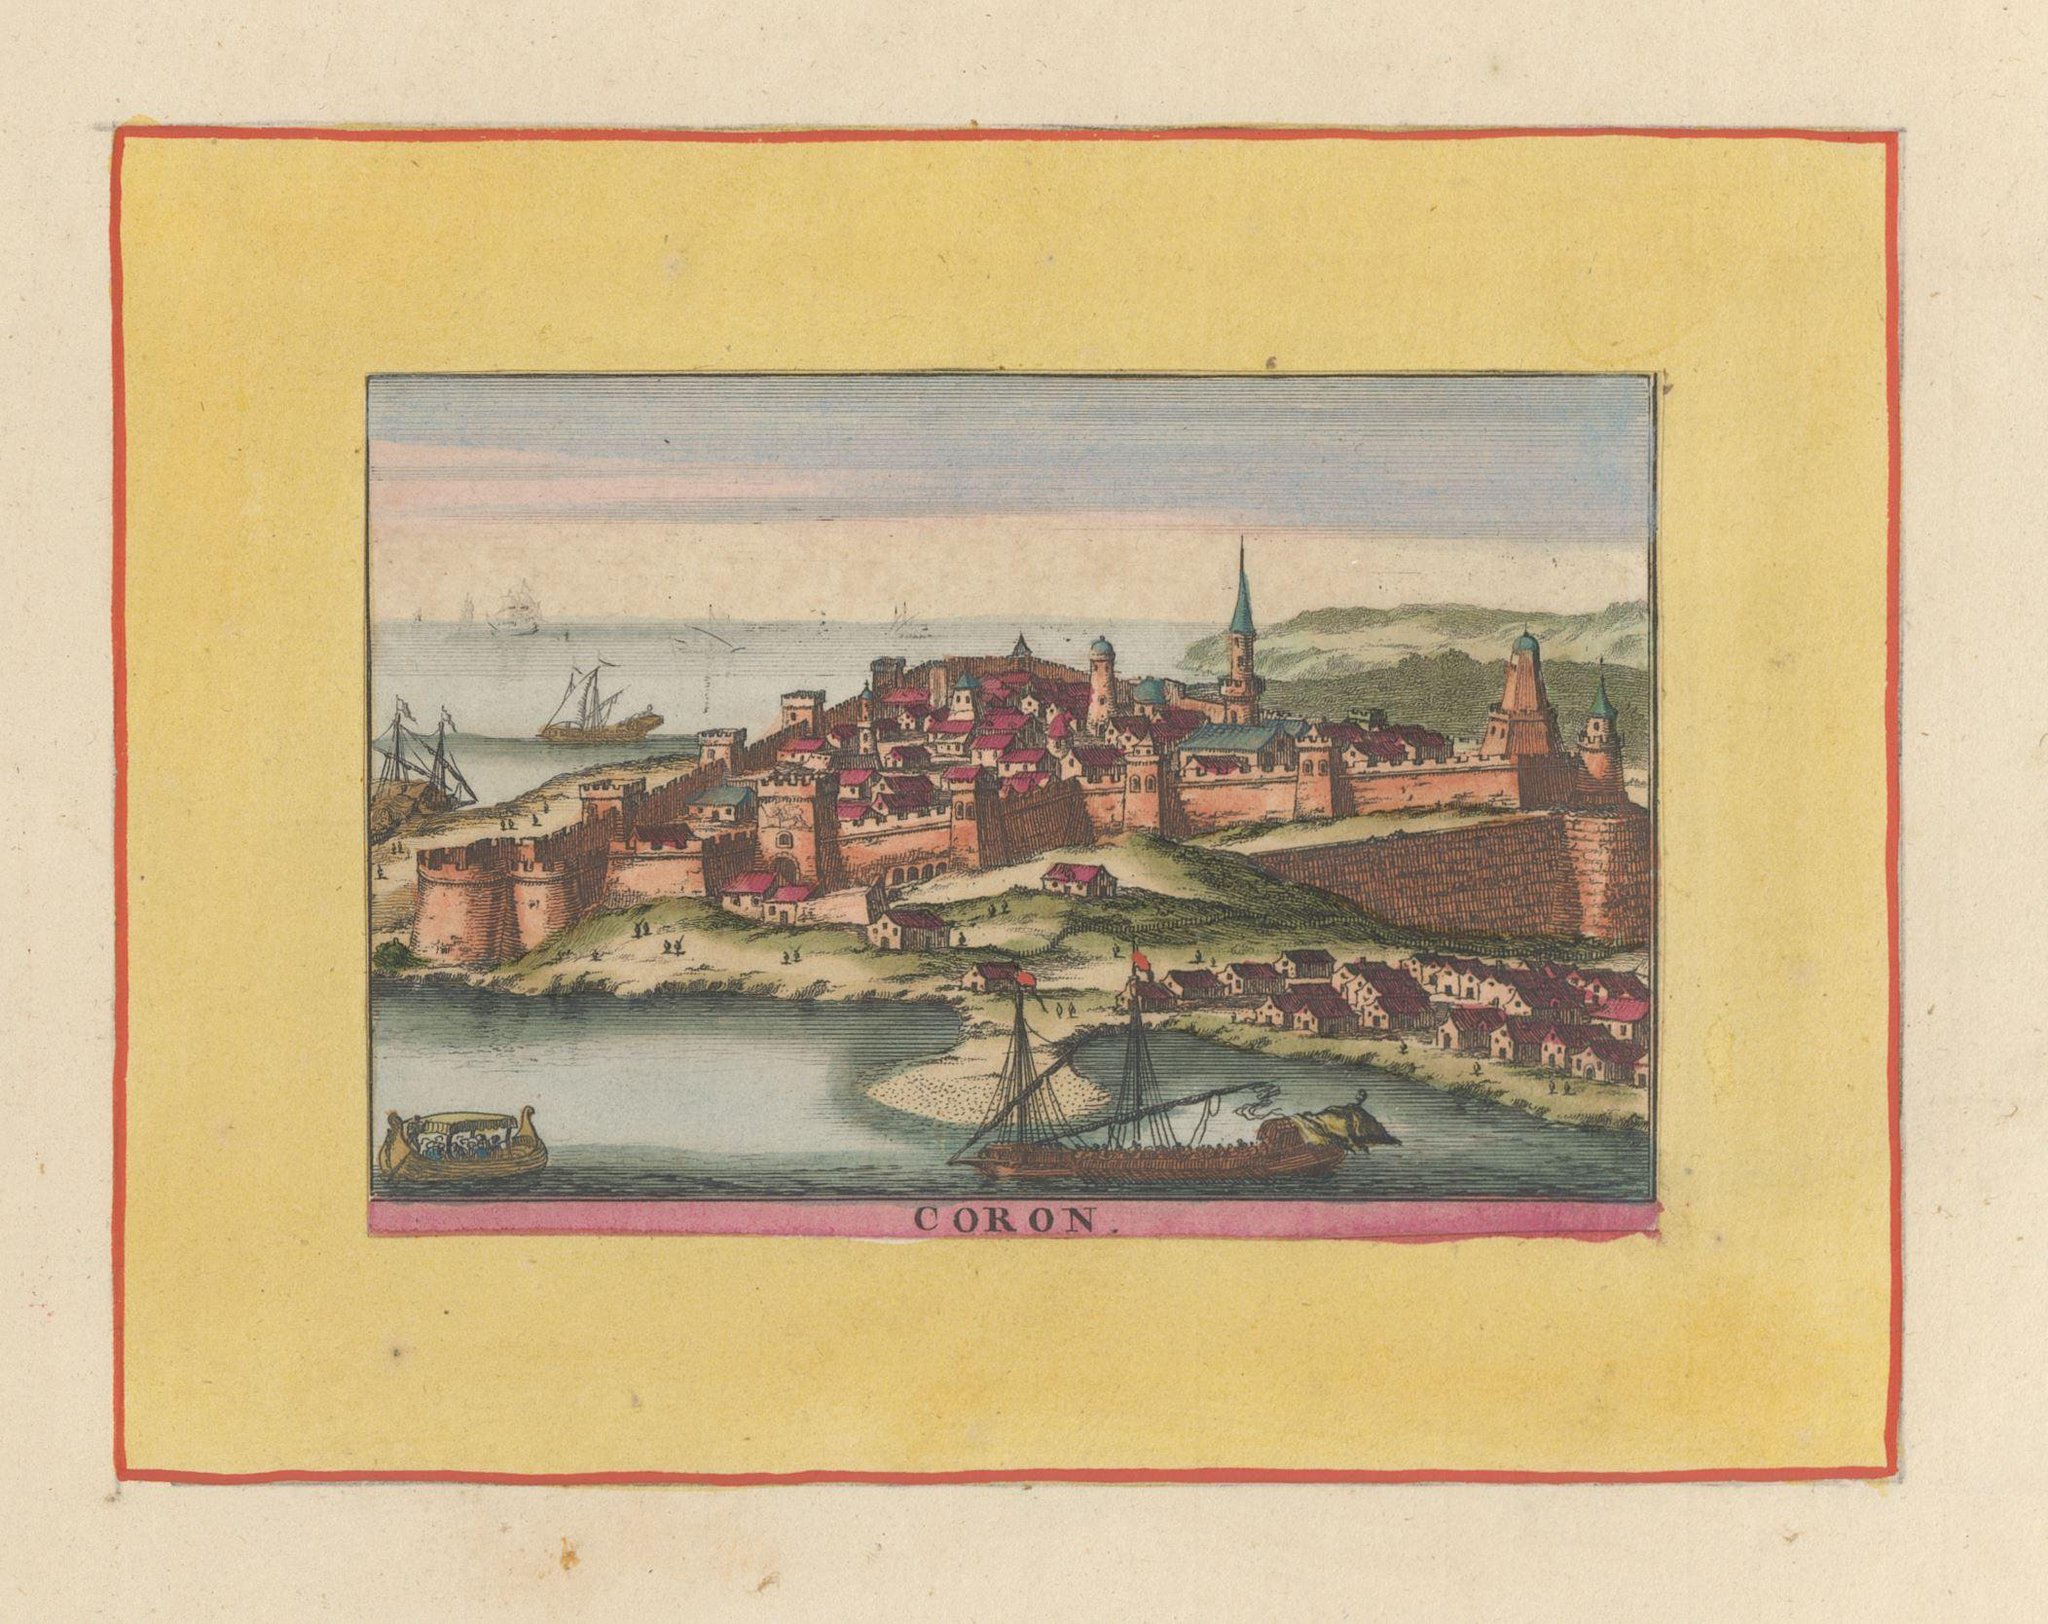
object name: album leaf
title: Griekse vestingsteden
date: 1679-1702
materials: paper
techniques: colour, etching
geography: the hague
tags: city-view, and landscape with man-made constructions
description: Prent maakt deel uit van een set van 16 prenten met voorstellingen van Griekse vestingsteden, oorspronkelijk gedrukt op één blad, die gebruikt konden worden als sieraad rond een kaart.